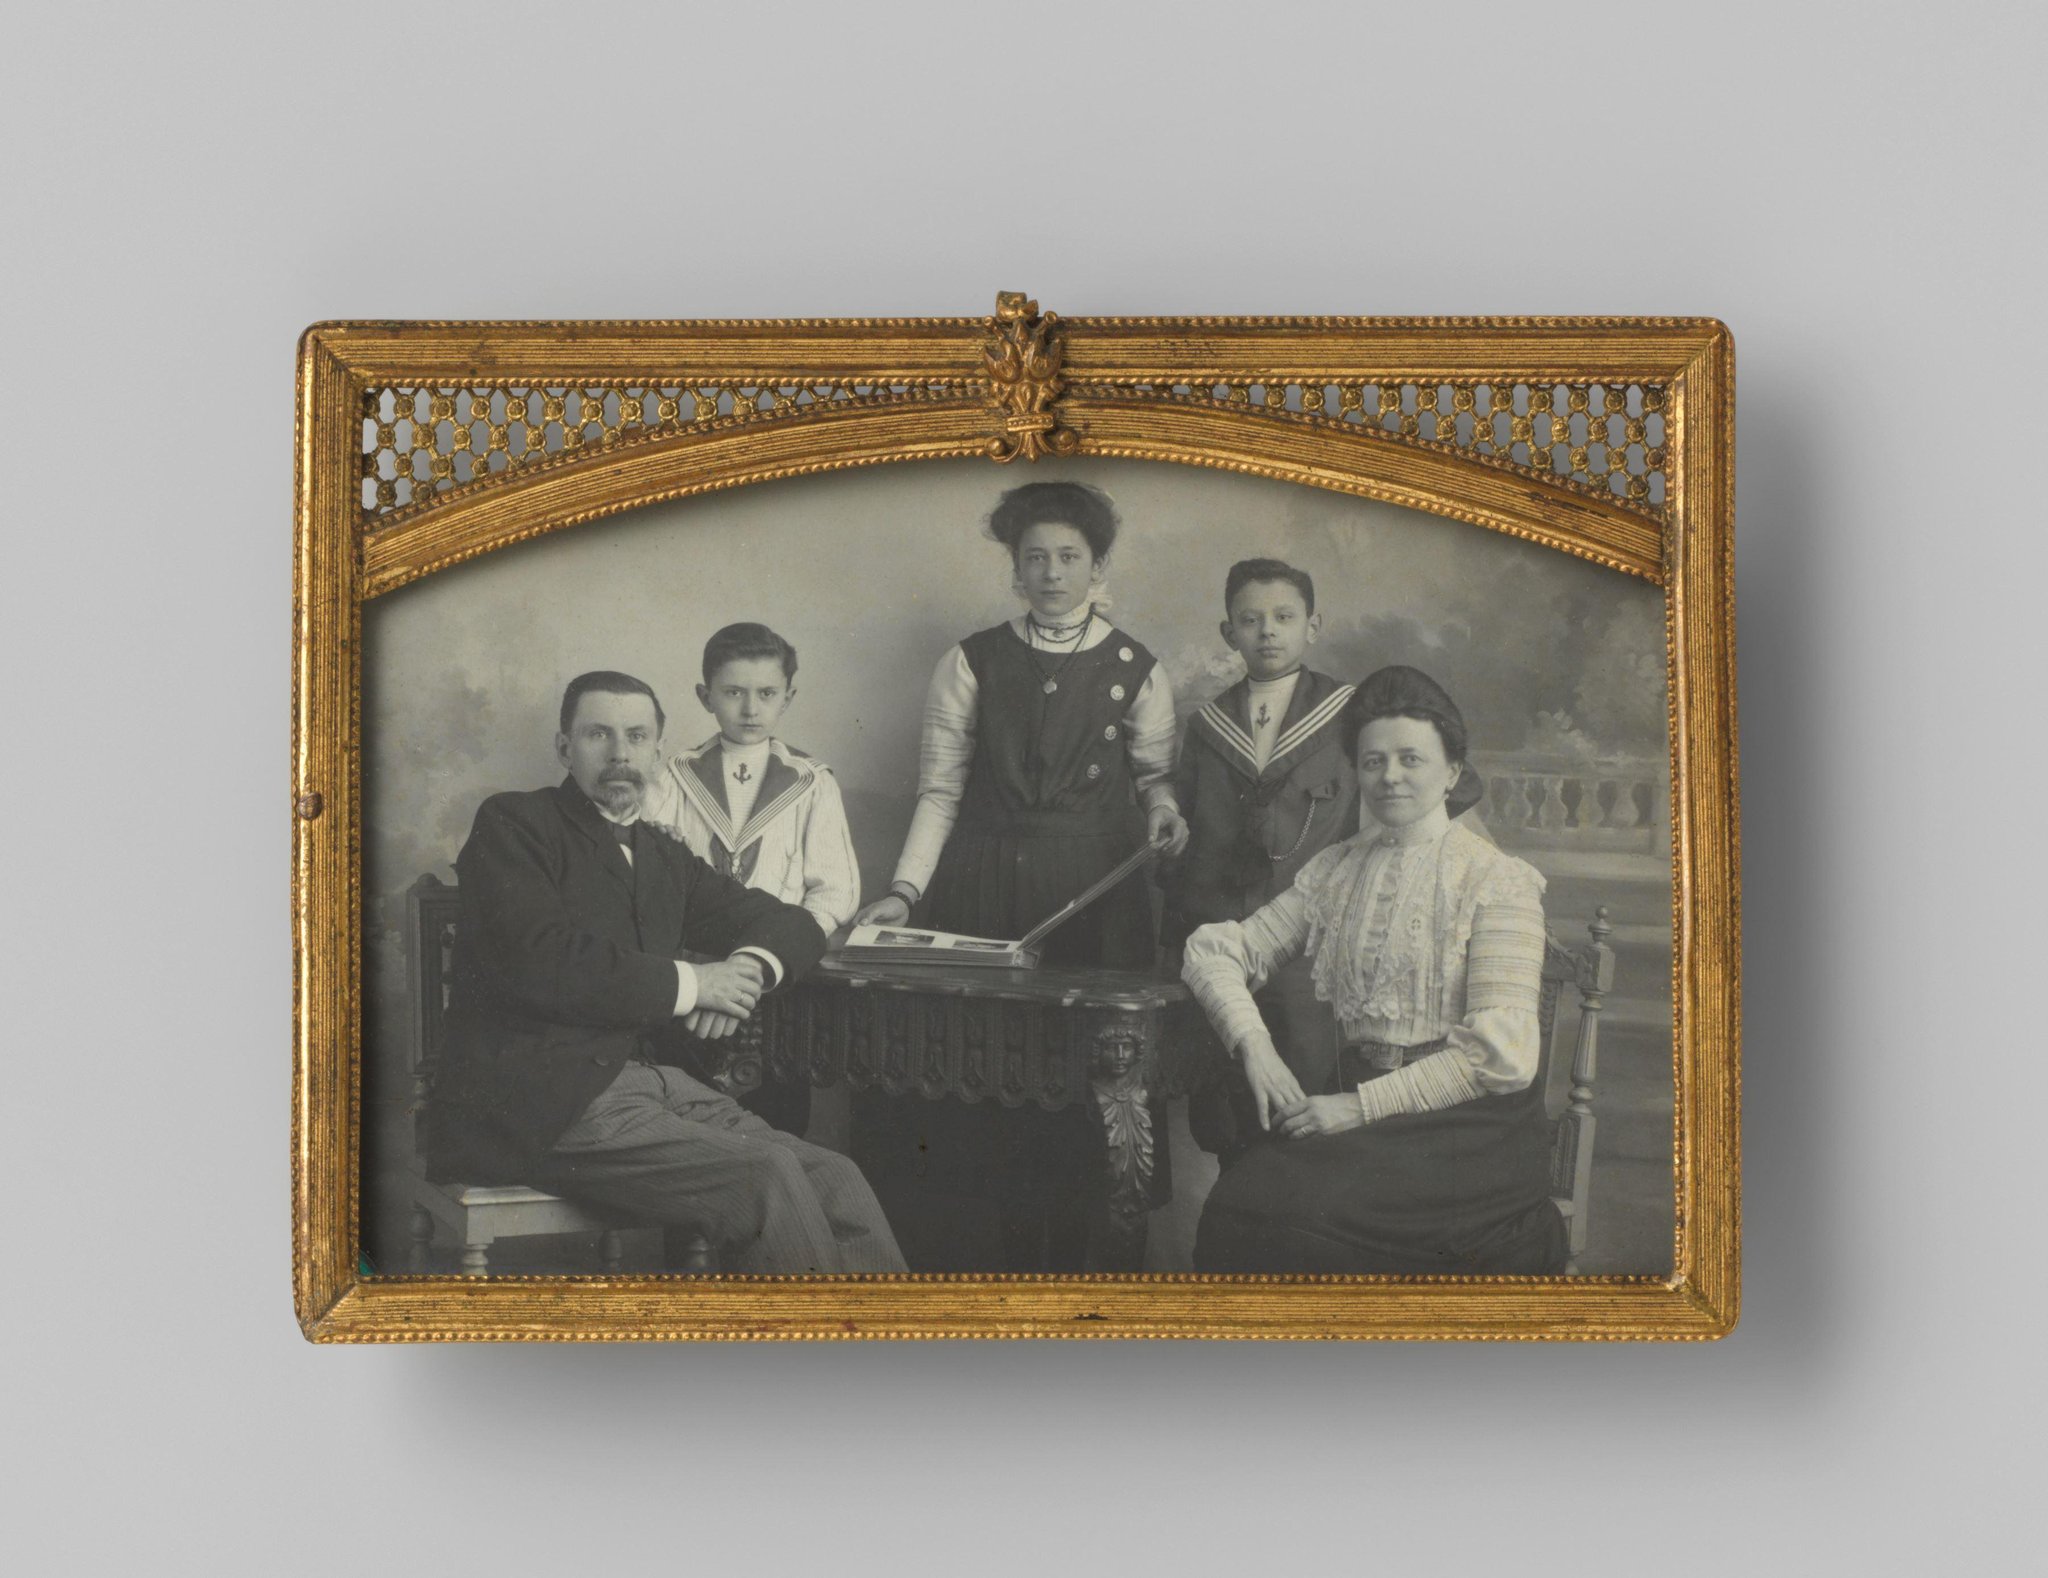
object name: frame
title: Groepsportret van een onbekende familie, rond een tafel met een fotoalbum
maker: Anonymous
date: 1890-1910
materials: paper, cardboard, glass, metal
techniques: gelatin silver print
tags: family group, especially parents with their child(ren), anonymous historical person portrayed